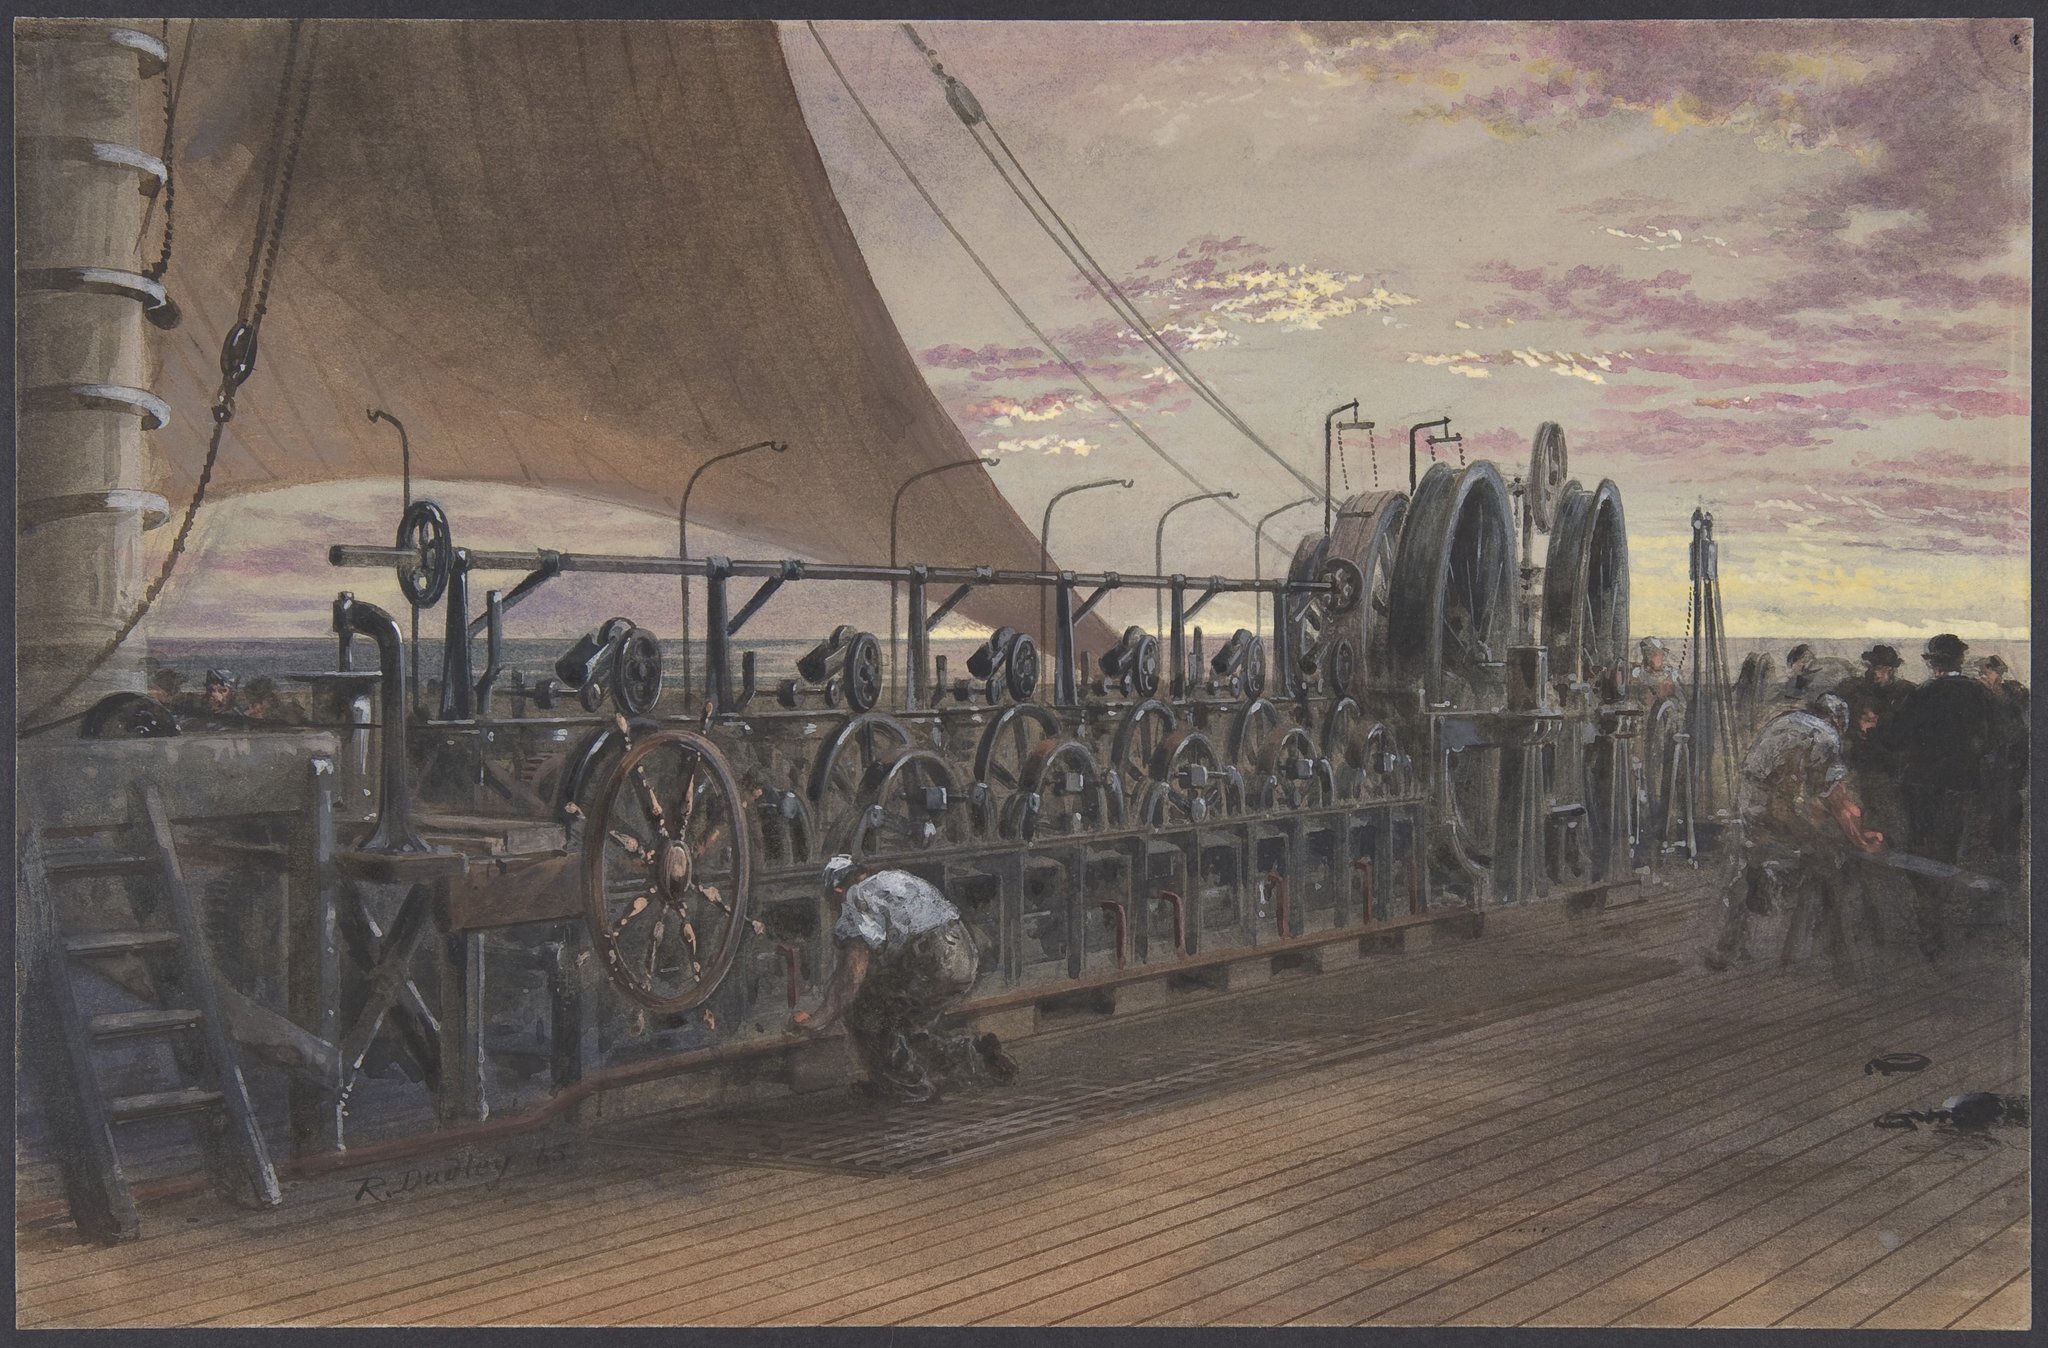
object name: drawing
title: The Paying-out Machinery in the Stern of the Great Eastern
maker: robert charles dudley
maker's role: artist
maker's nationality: british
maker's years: 1826-1909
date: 1865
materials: gouache, graphite, watercolor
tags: industry,ships,transatlantic cable